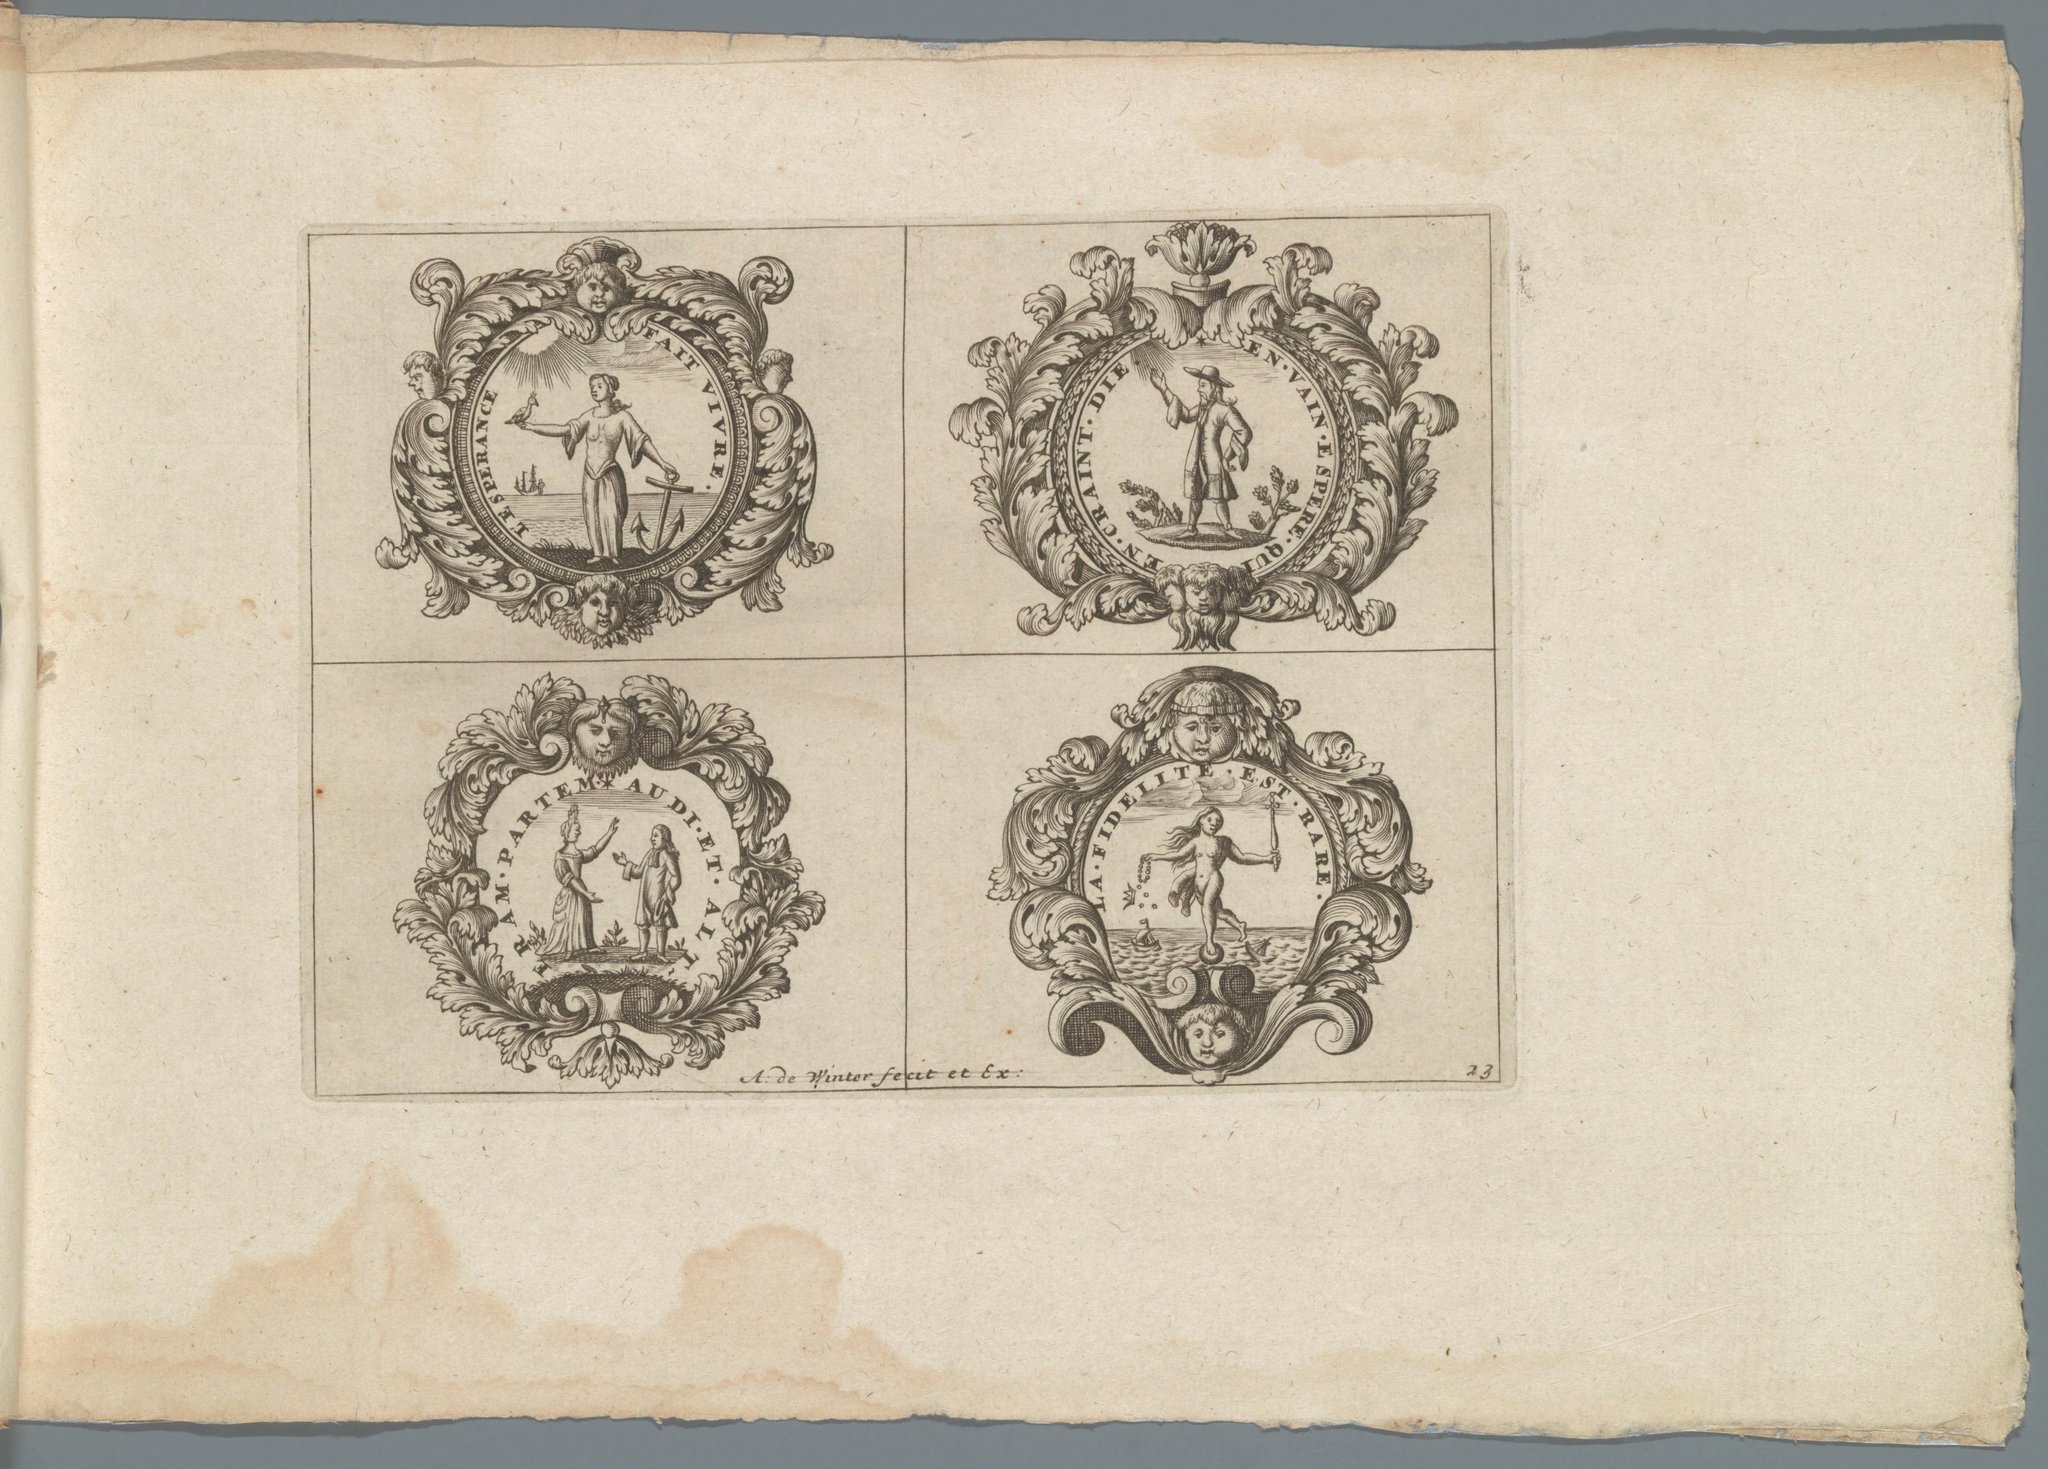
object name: print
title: Livre des plus belles devises enrichies des fleurons et d'autres ornaments nouvellement inventes, etc. ...Tome second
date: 1697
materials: paper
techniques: etching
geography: amsterdam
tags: ornaments ~ art, symbolic representations, allegories and emblems ~mind, spirit, symbols of human life, love: 'frau minne' and other allegories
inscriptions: date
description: Prent nr. 23 van een serie van twaalf genummerde prenten (inclusief titelblad) met deviezen betreffende de liefde en andere levenszaken. De deviezen bestaan uit een pictura en een motto in het Latijn. Deel twee van twee genummerde reeksen. Het is de eerste uitgave (en eerste staat) van de uitgave, voor het adres van Cornelis Danckerts II en de toevoeging van Nederlandse teksten.